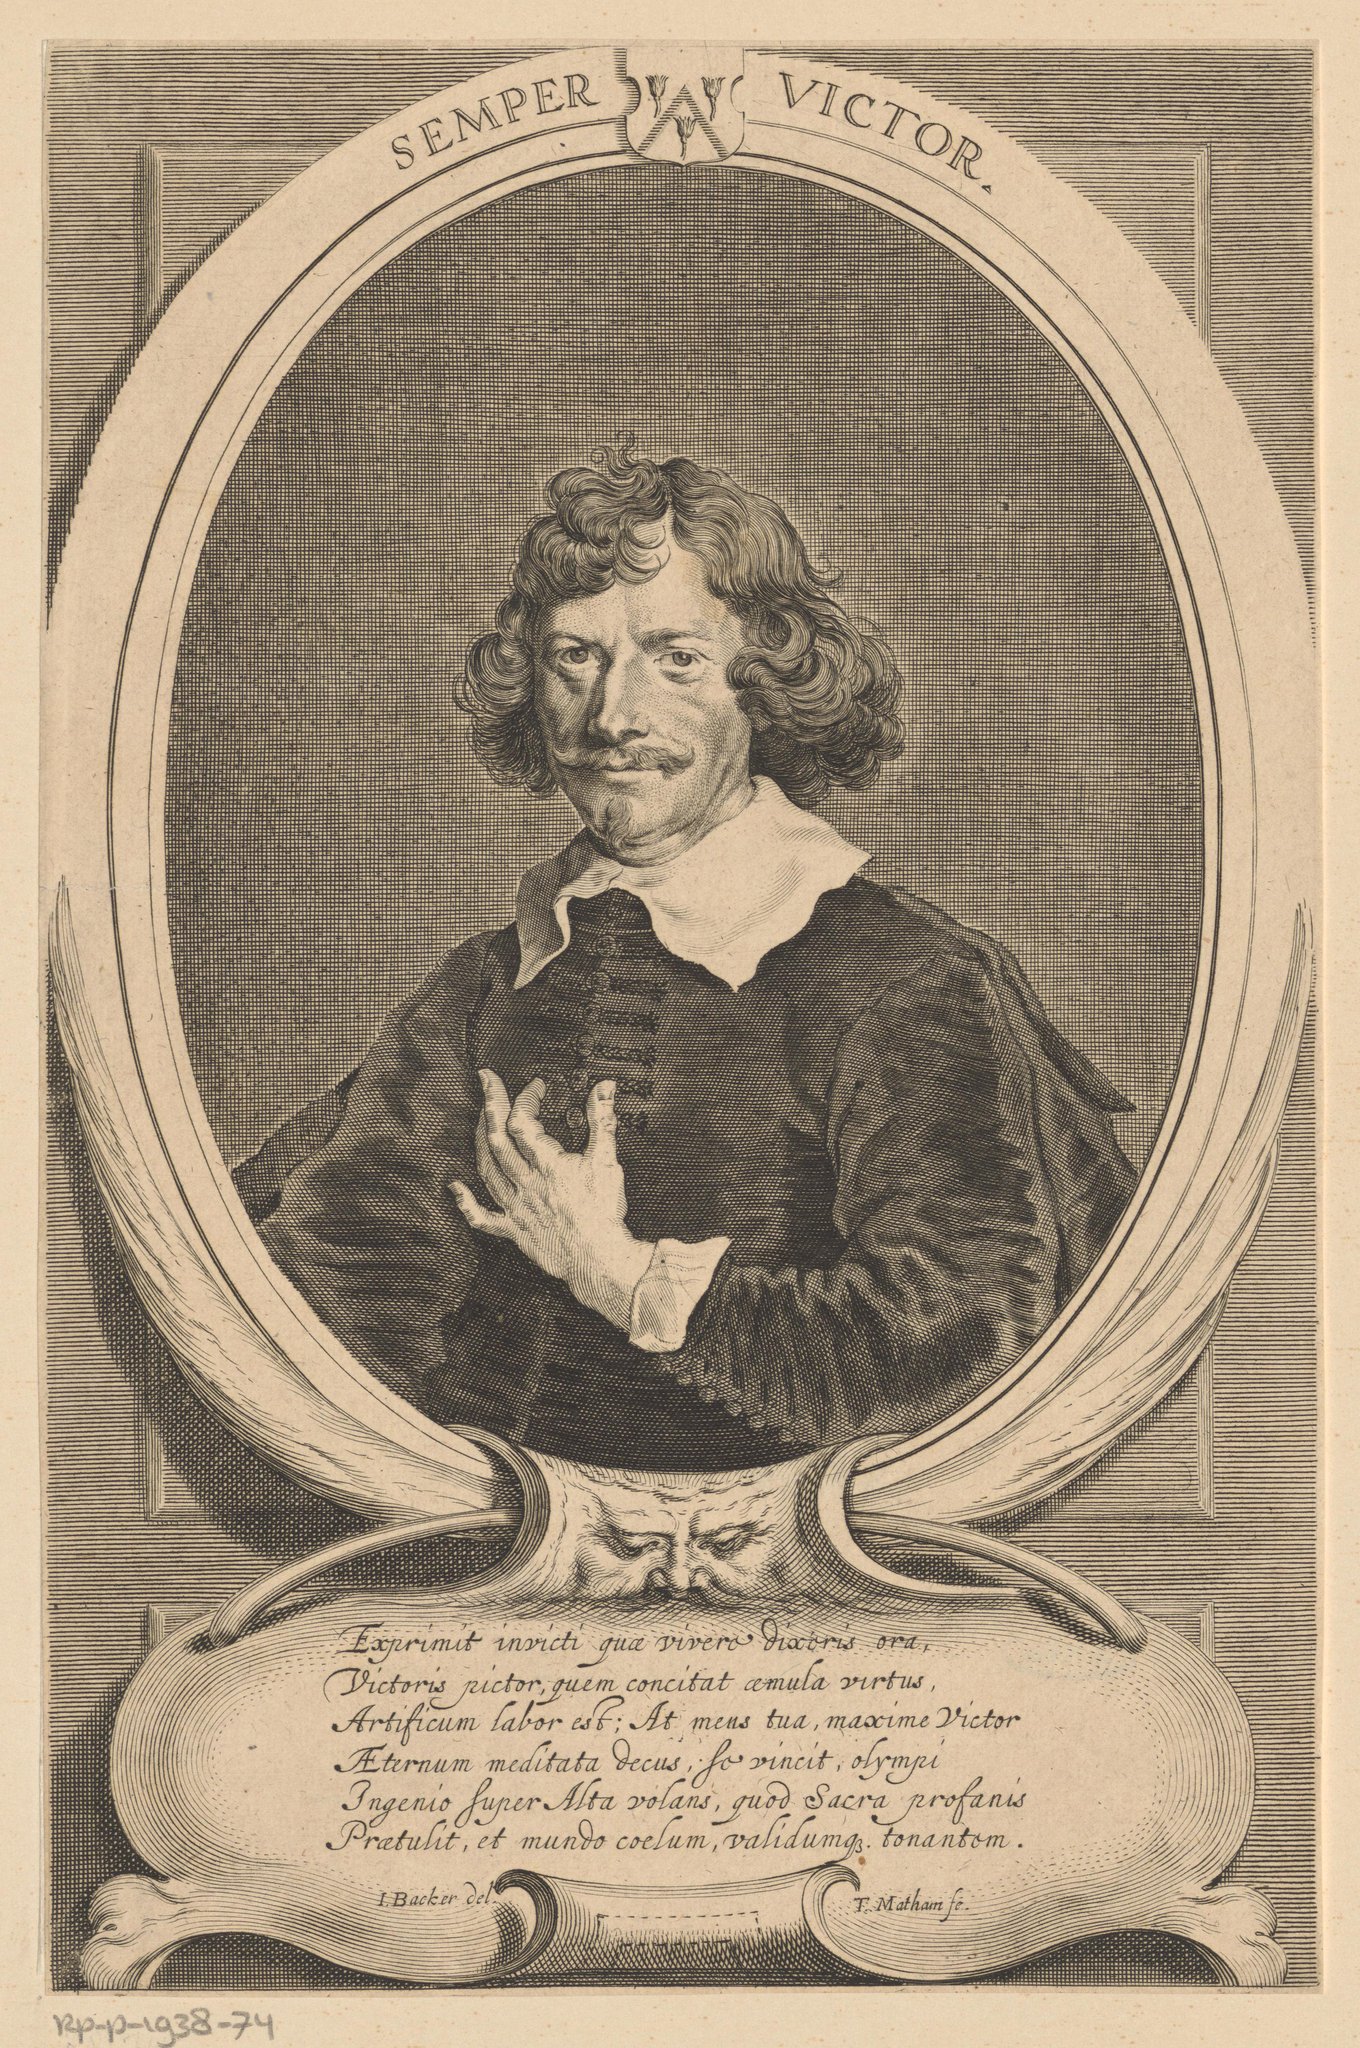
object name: print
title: Portret van Jan Victors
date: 1650-1676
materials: paper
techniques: engraving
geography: northern netherlands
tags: painter, jan victors, historical persons, portrait, self-portrait of painter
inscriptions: collector's mark: Lugt 2228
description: Met zesregelig onderschrift in het Latijn.